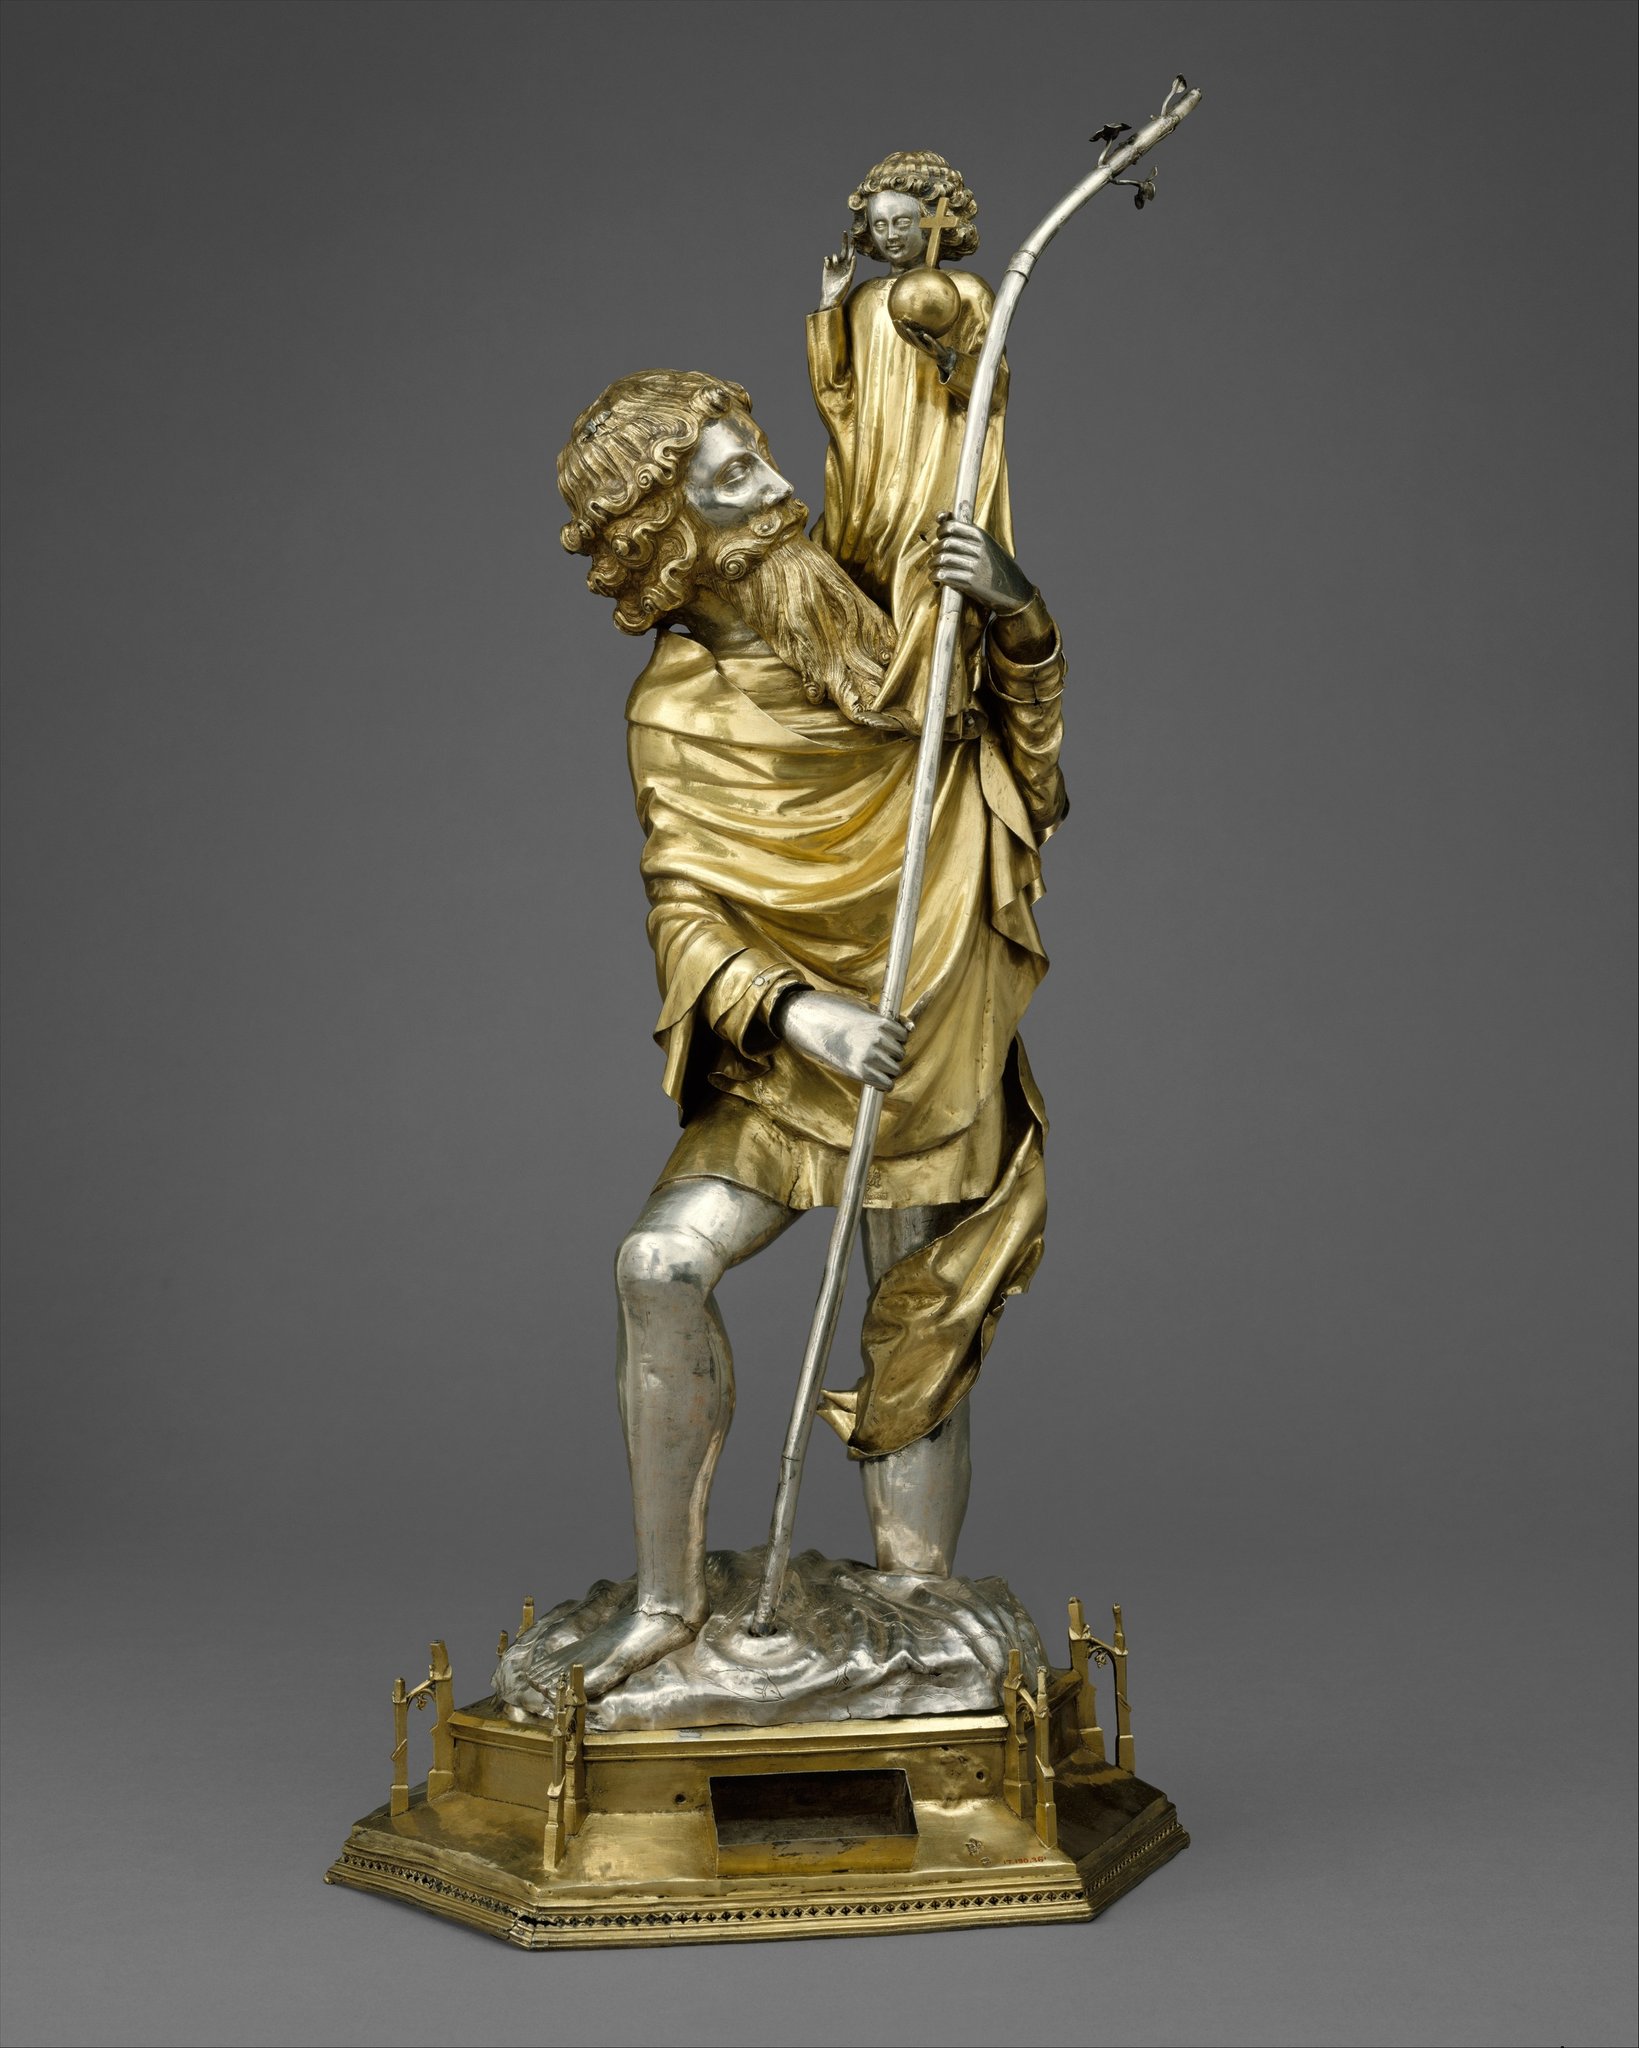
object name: reliquary statuette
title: Reliquary Statuette of Saint Christopher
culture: french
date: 1375-1425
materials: silver, silver gilt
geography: toulouse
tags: christ,saint christopher